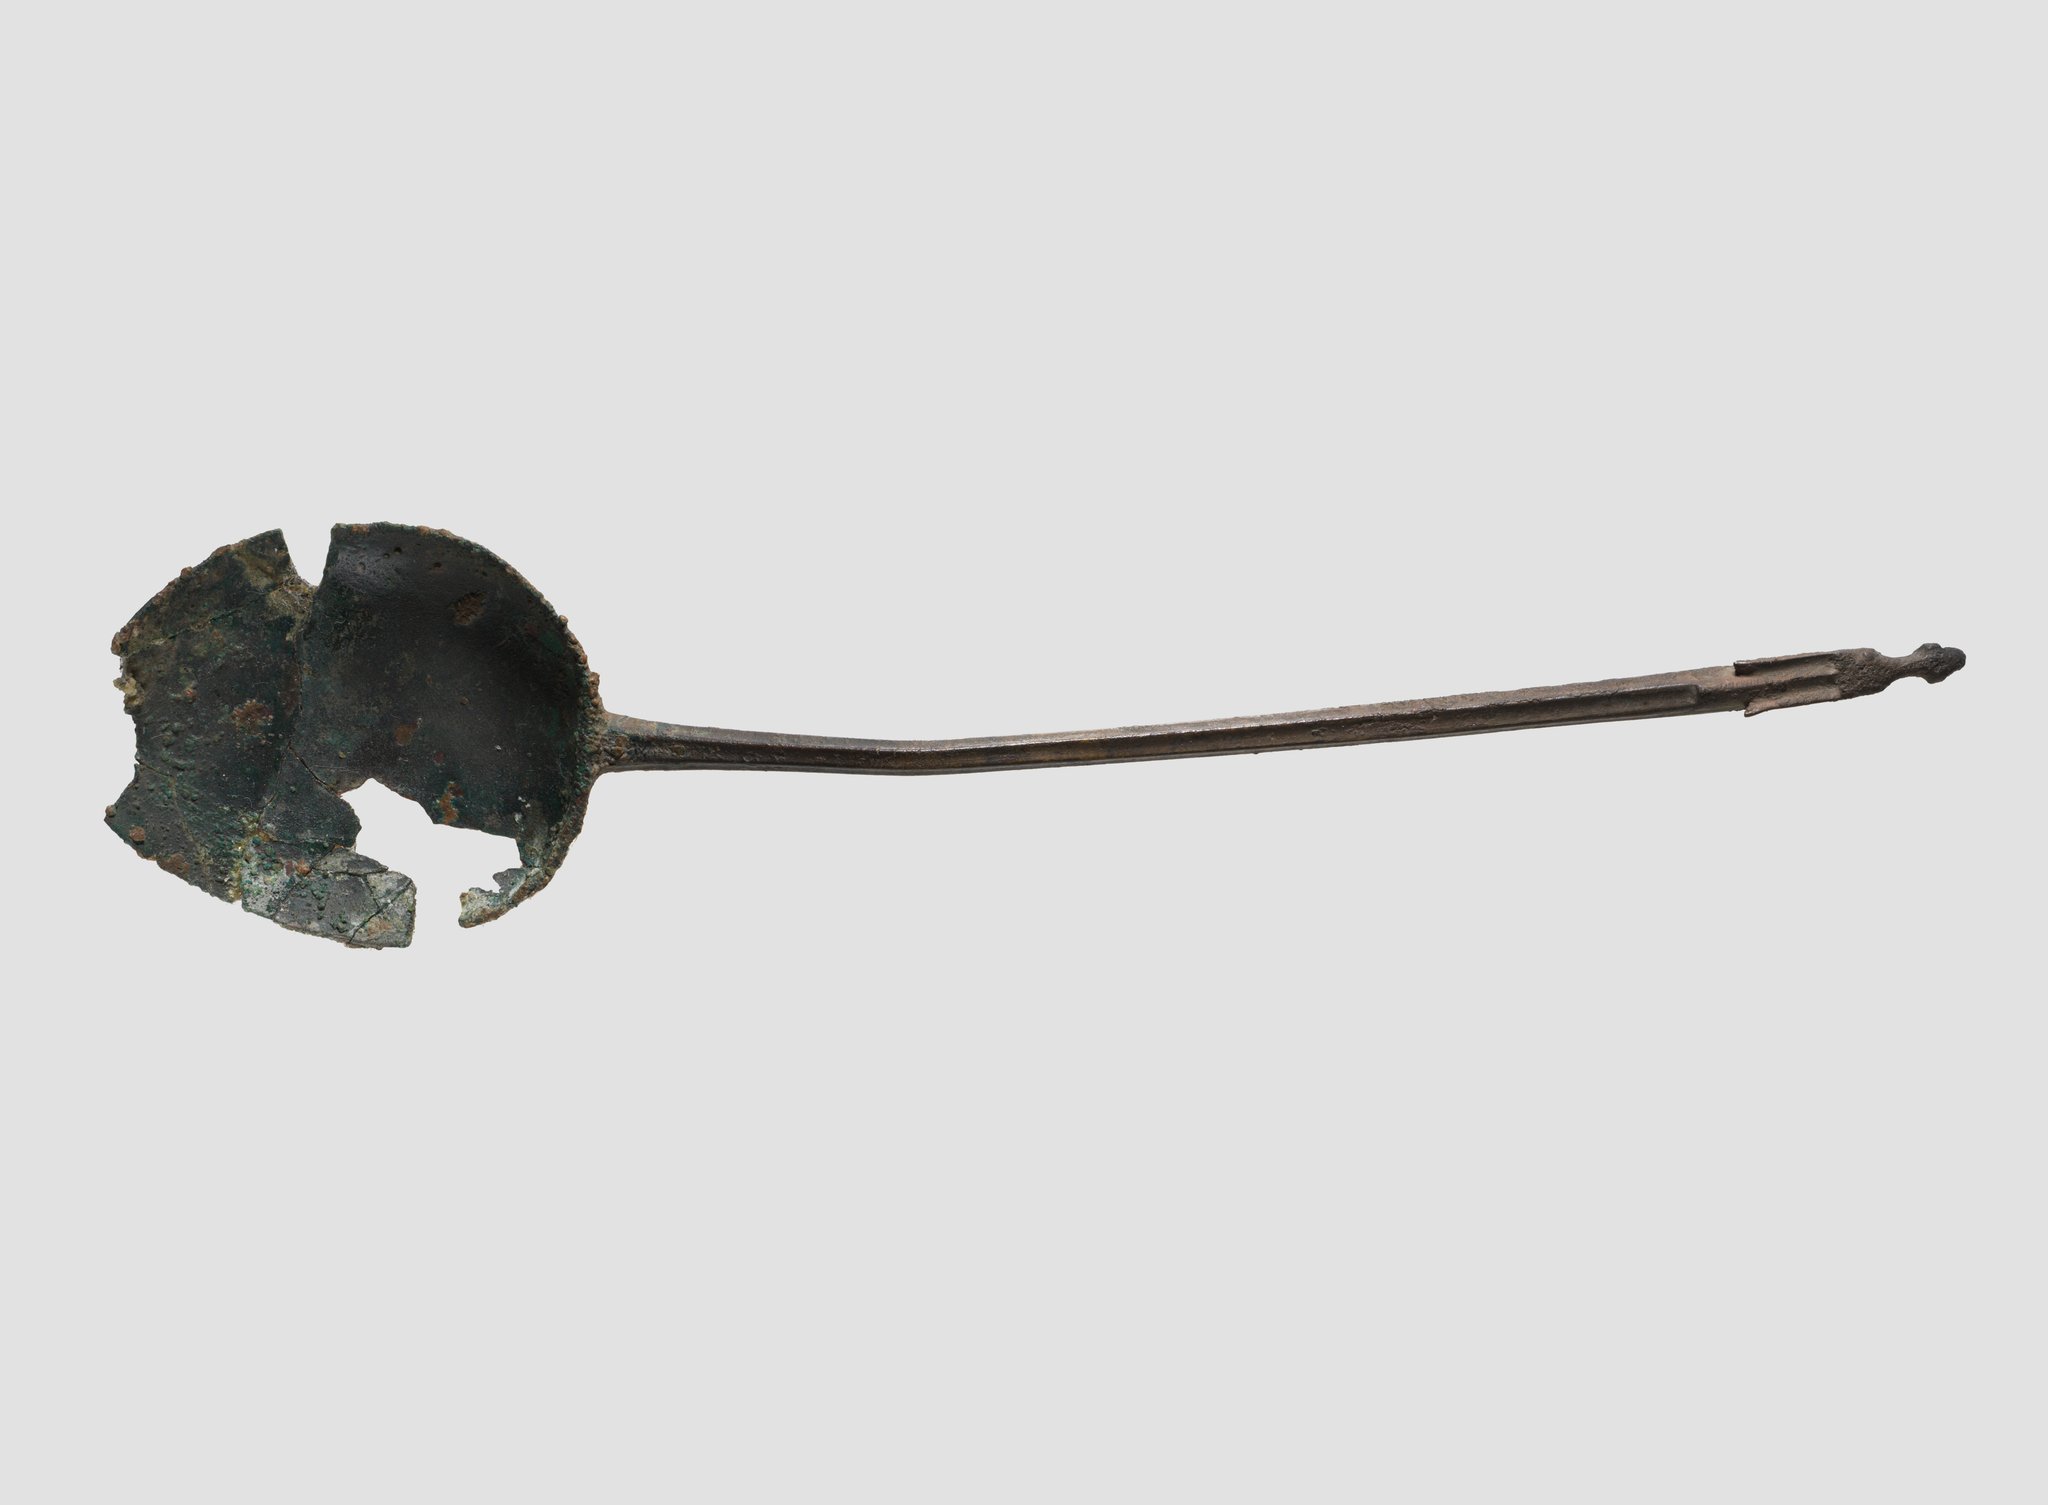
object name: spoon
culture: sasanian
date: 201-700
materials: bronze, copper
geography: iran